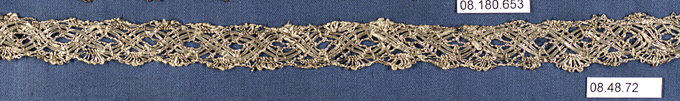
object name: strip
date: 1750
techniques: lace